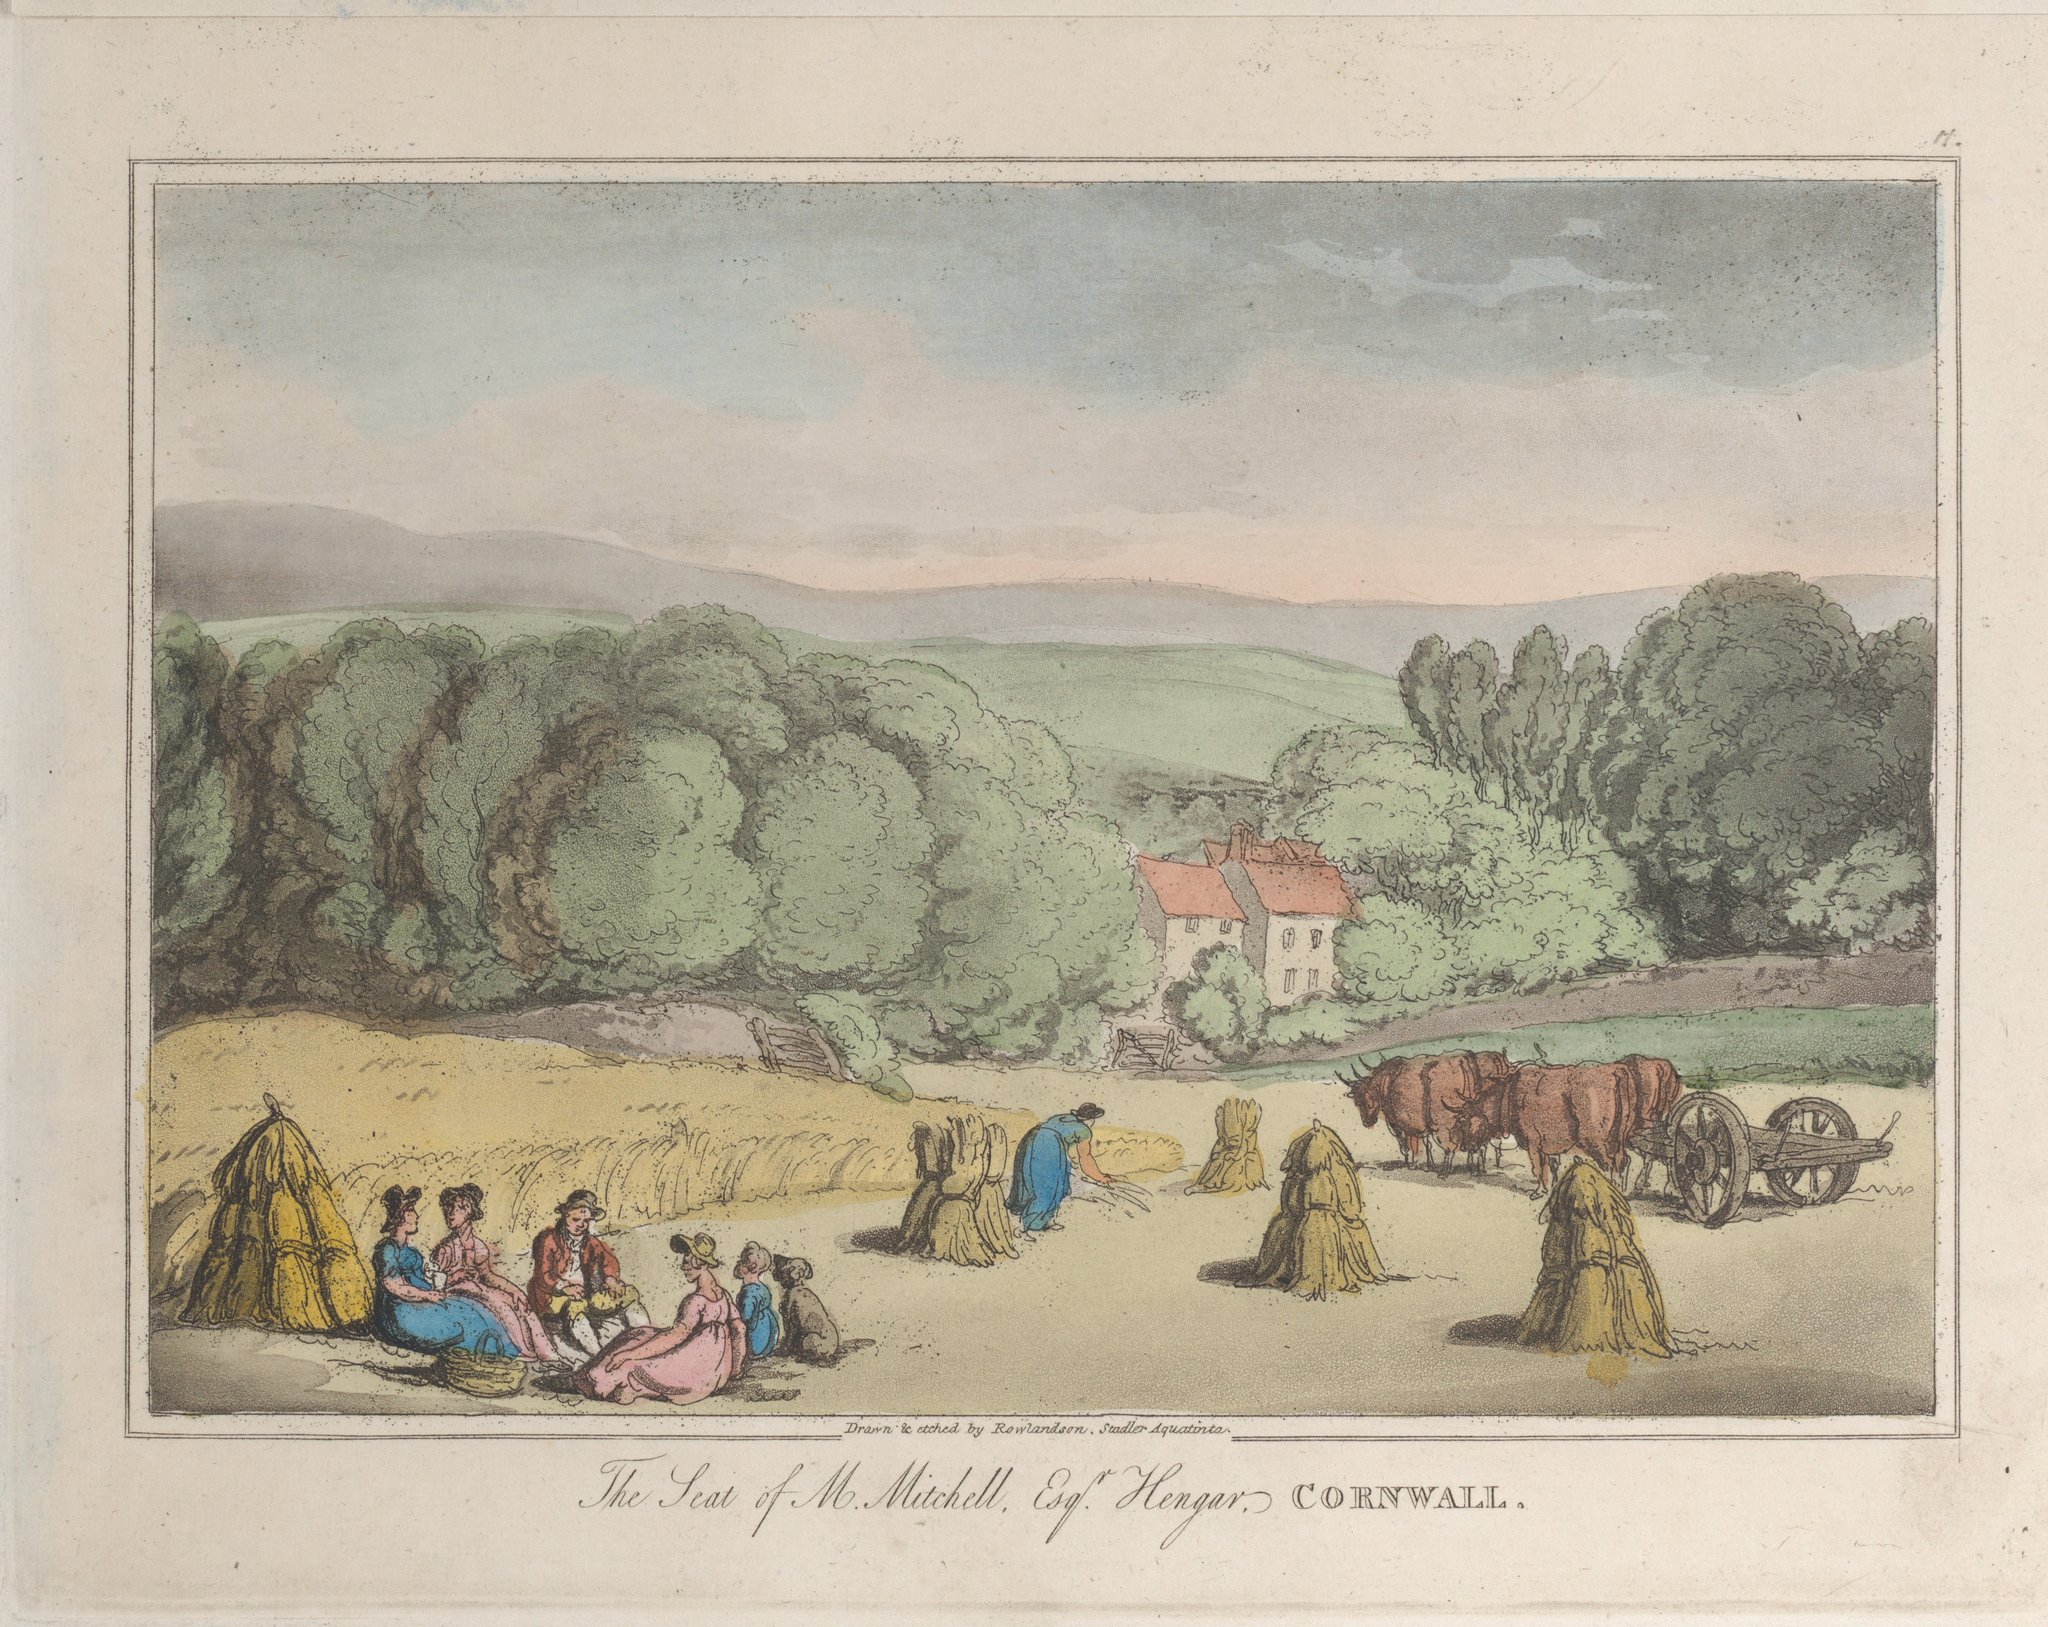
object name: print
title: The Seat of M. Mitchell Esq. Henger, Cornwall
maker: thomas rowlandson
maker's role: artist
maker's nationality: british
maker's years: 1757-1827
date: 1822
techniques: aquatint, etching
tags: farms,landscapes